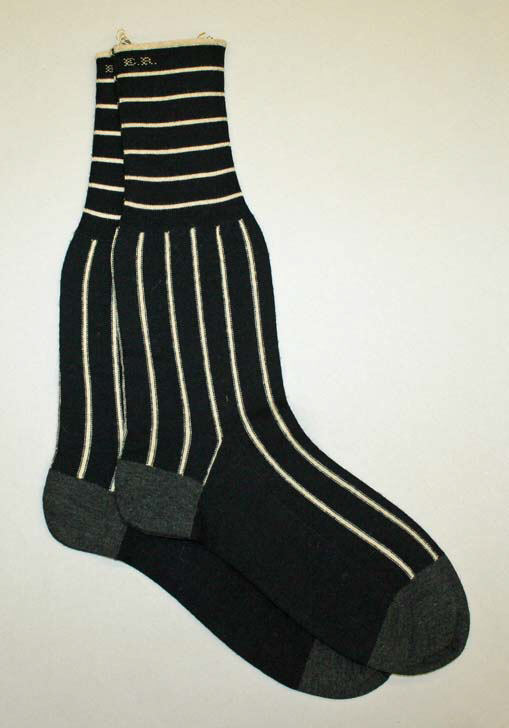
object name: sock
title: Socks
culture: british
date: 1870-1879